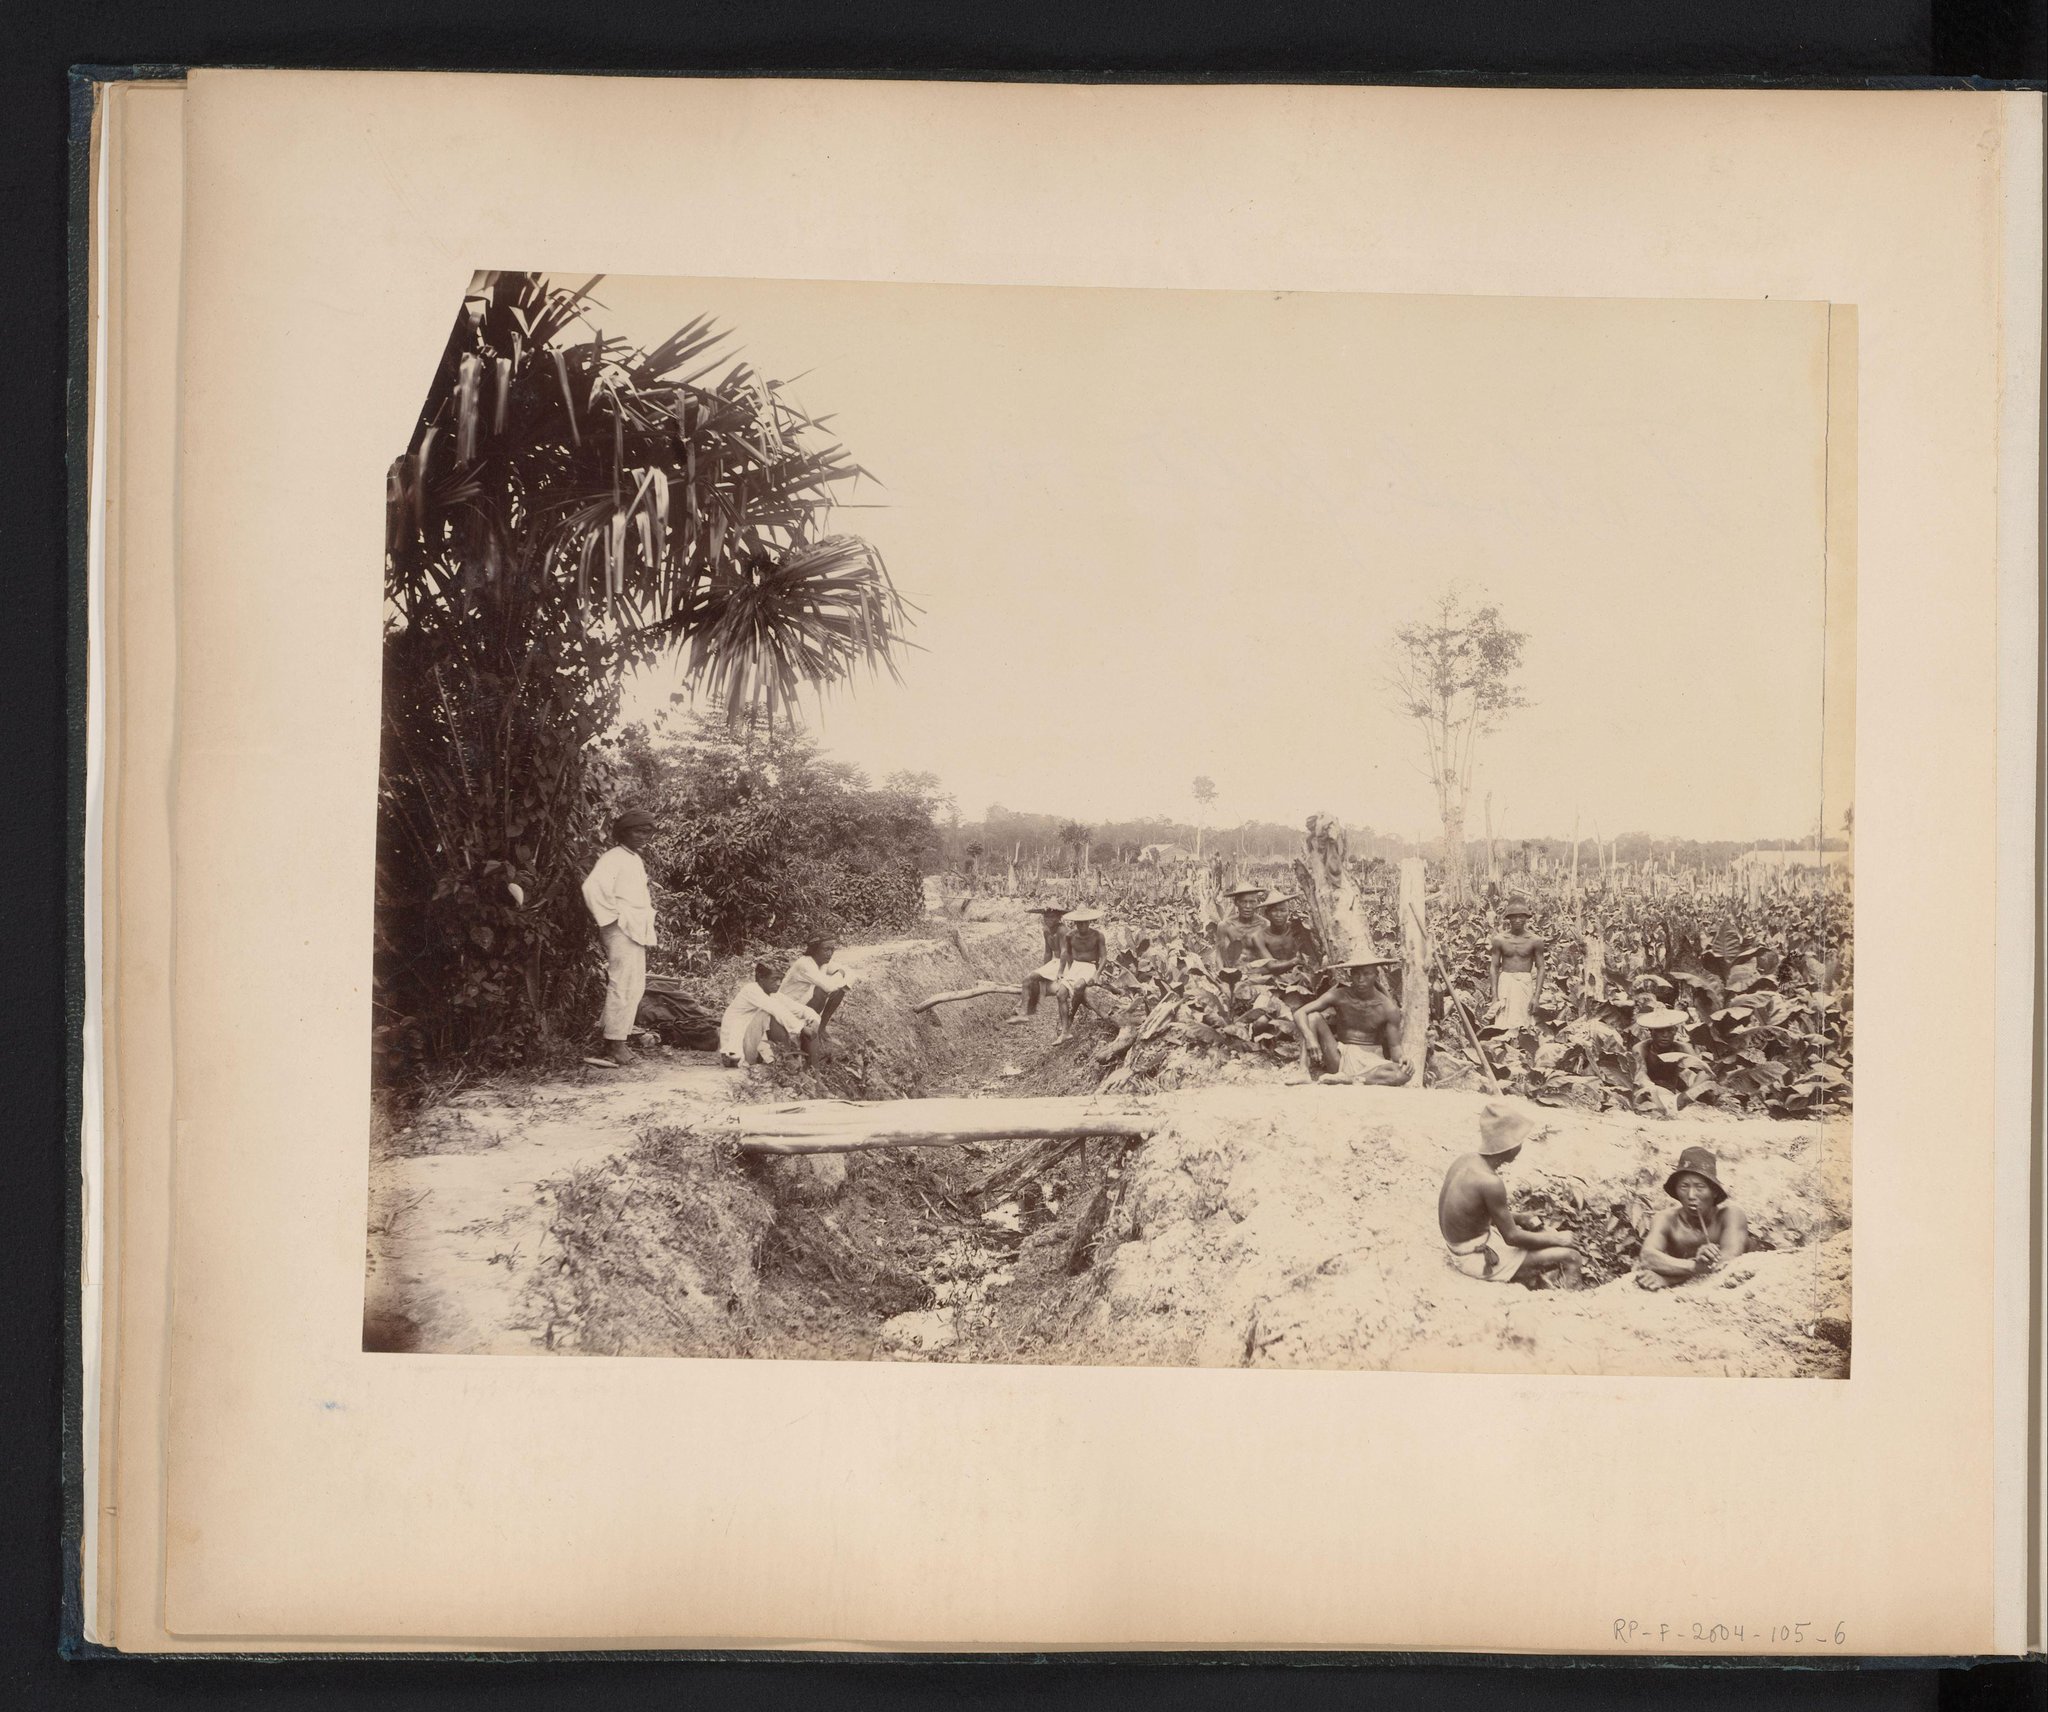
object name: photograph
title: Coolies on a tobacco plantation, probably Langkat, Sumatra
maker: Anonymous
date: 1890-1900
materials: cardboard, photographic support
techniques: albumen print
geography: sumatra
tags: plantation, working class, labourers, tobacco, sumatra